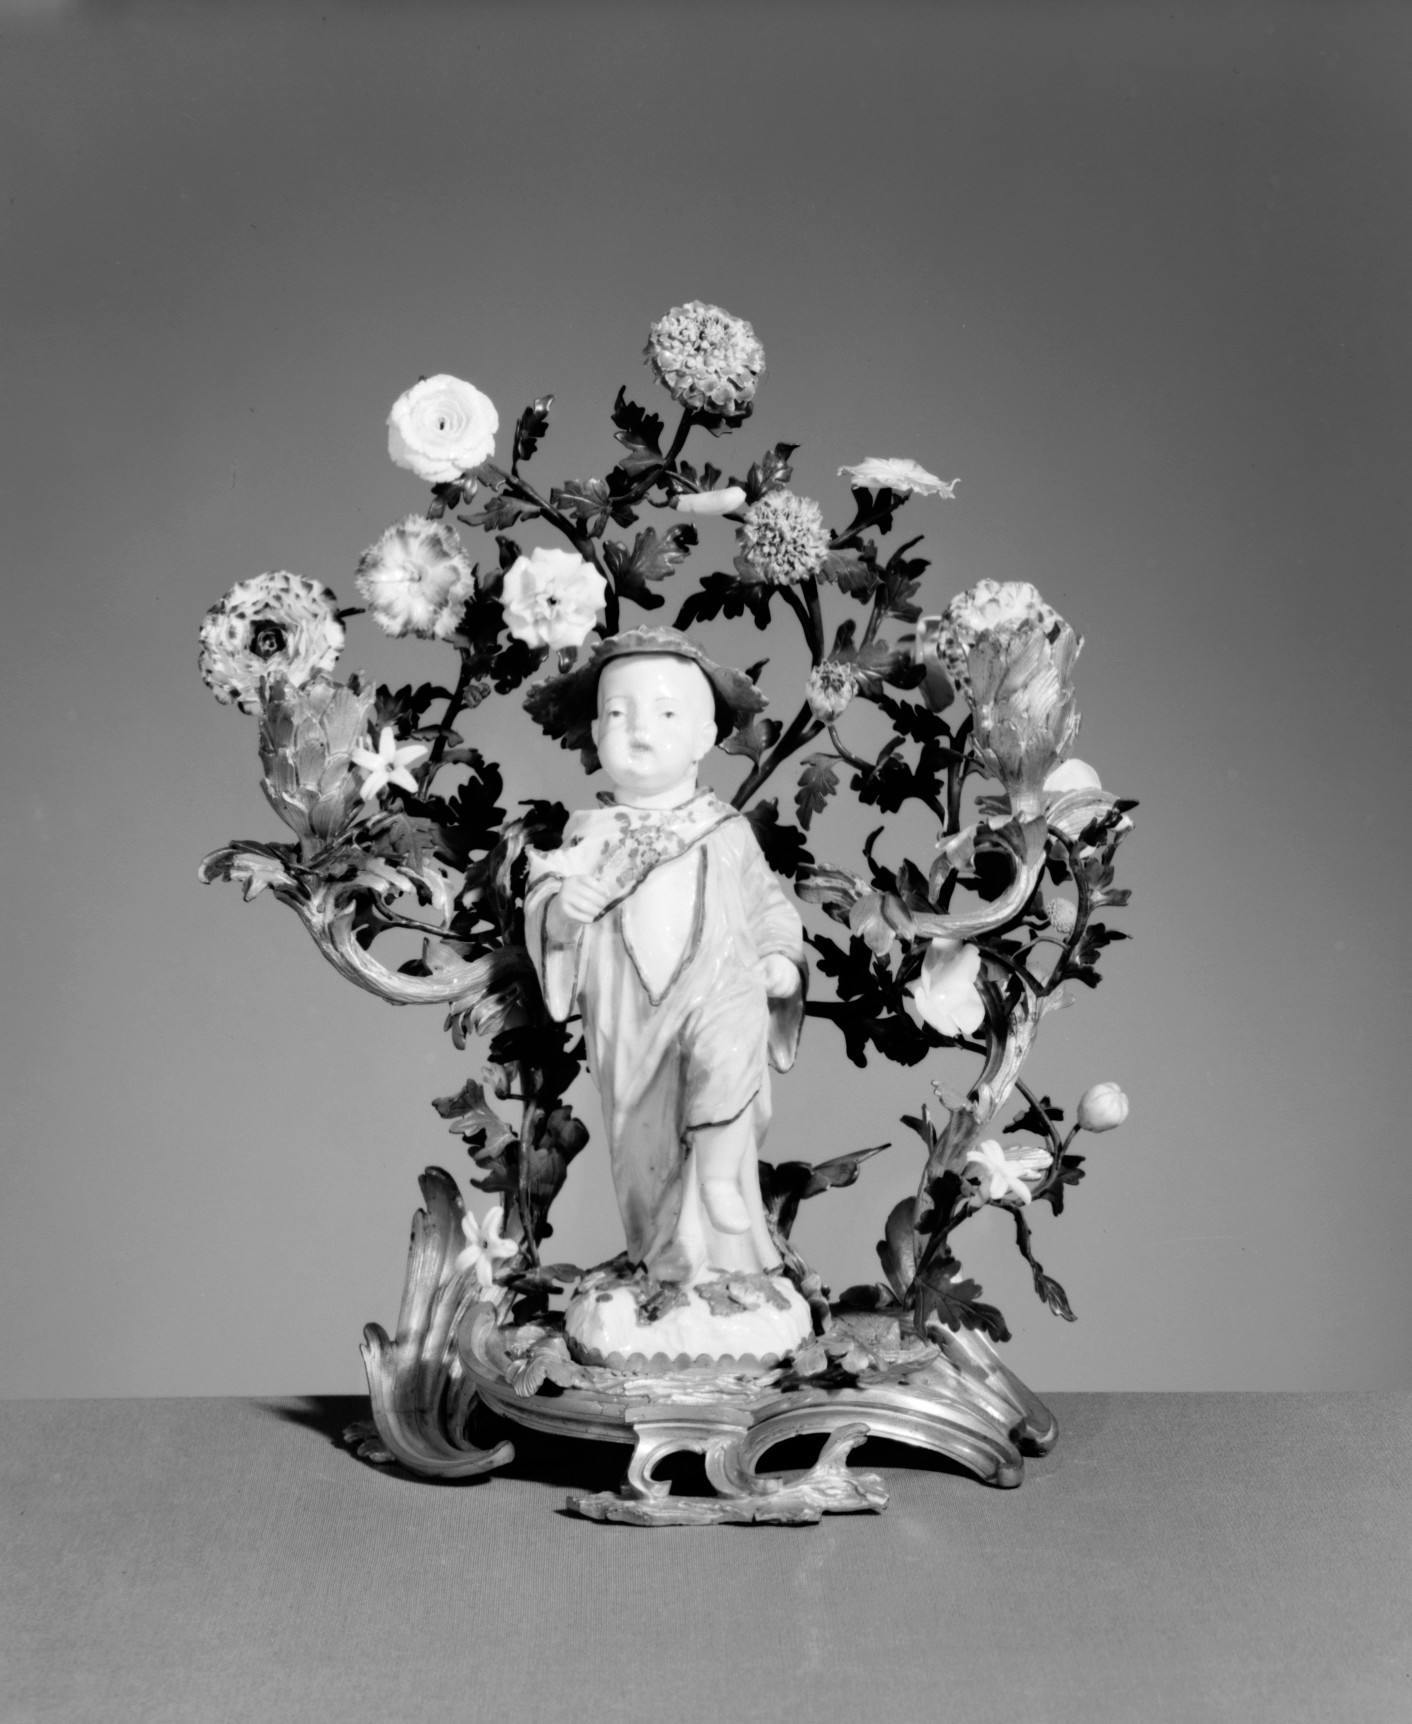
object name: candelabrum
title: Candelabrum (one of a pair)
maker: meissen manufactory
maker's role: manufactory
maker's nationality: german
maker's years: 1710-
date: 1745-1750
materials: gilt bronze, hard paste porcelain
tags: boys,flowers